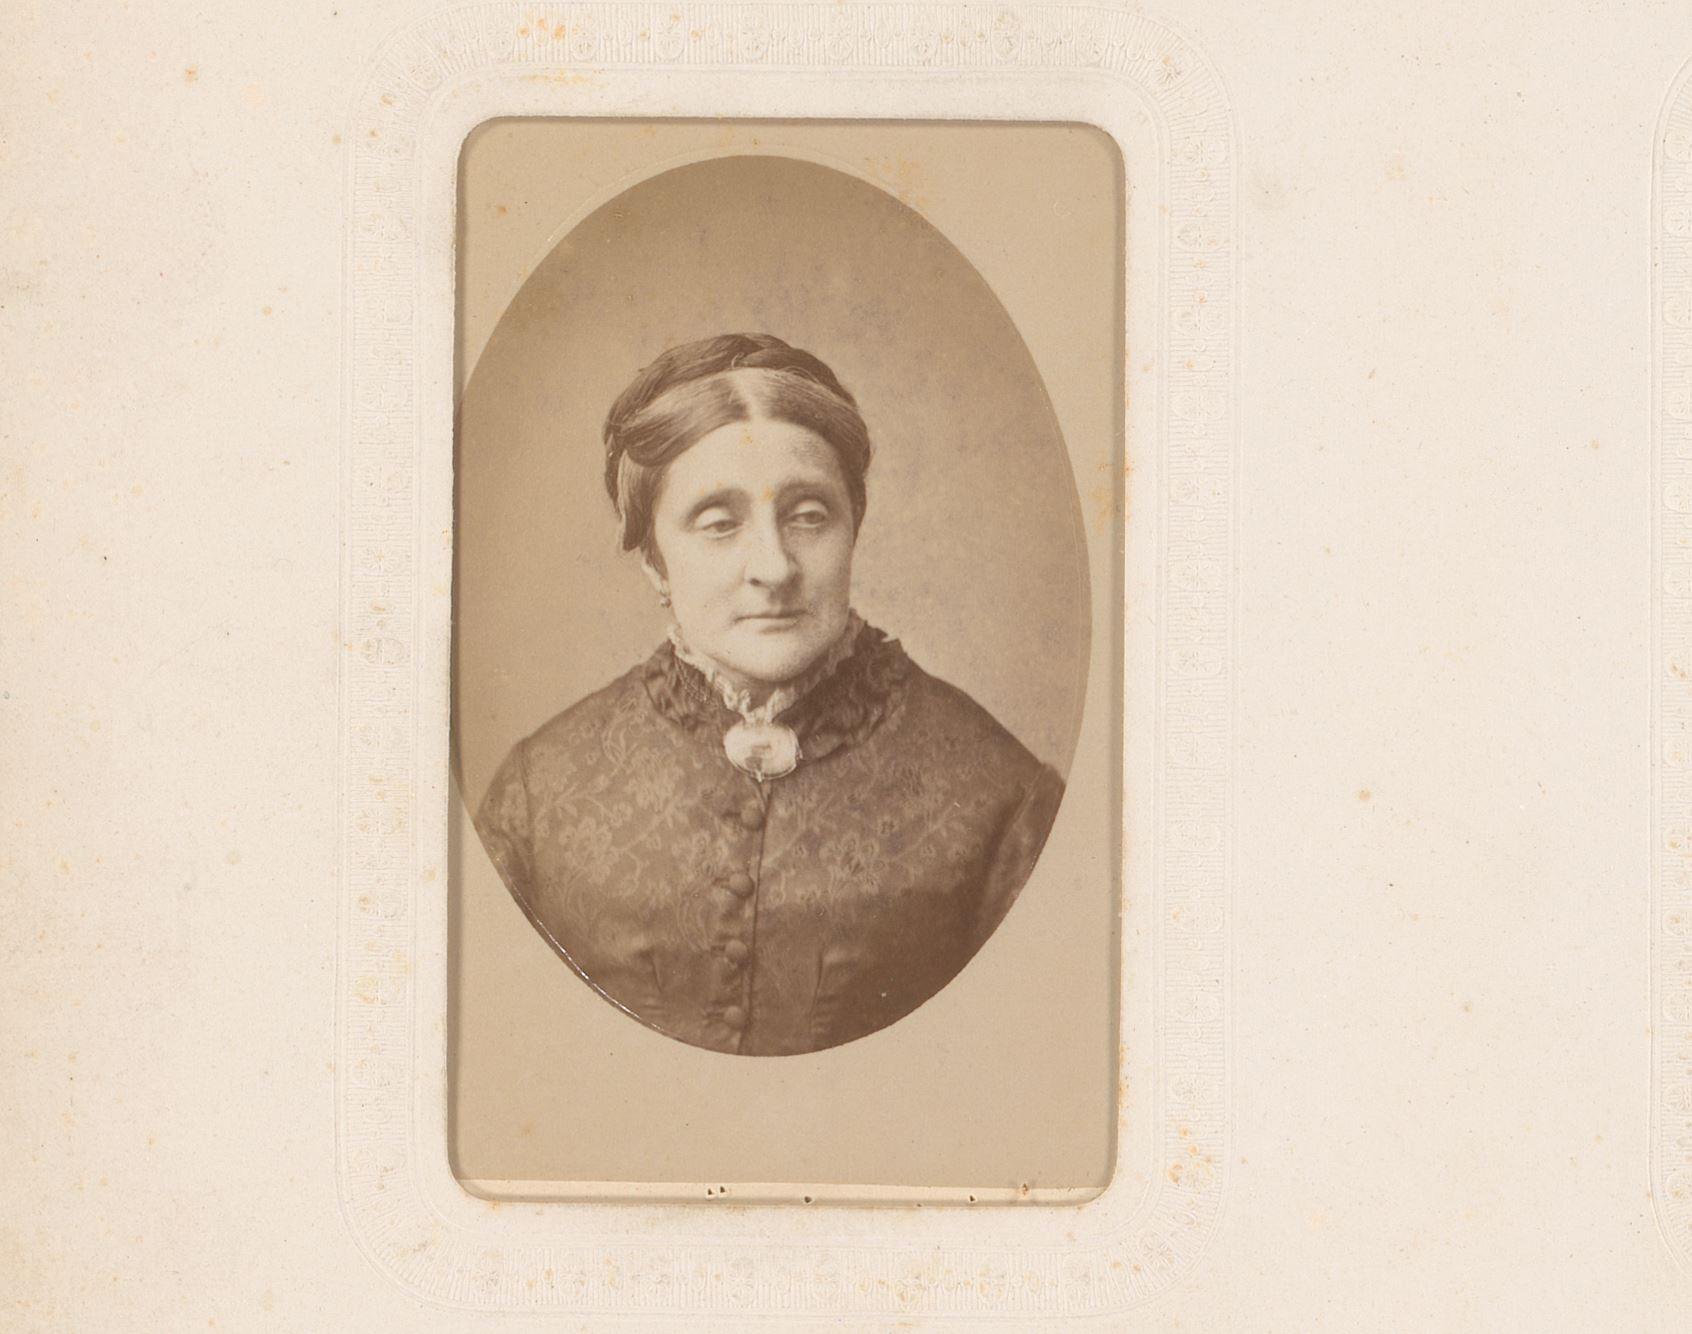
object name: album leaf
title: Portret van een vrouw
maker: Anonymous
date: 1860-1900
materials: cardboard, photographic support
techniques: albumen print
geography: netherlands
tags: historical persons - bb - woman